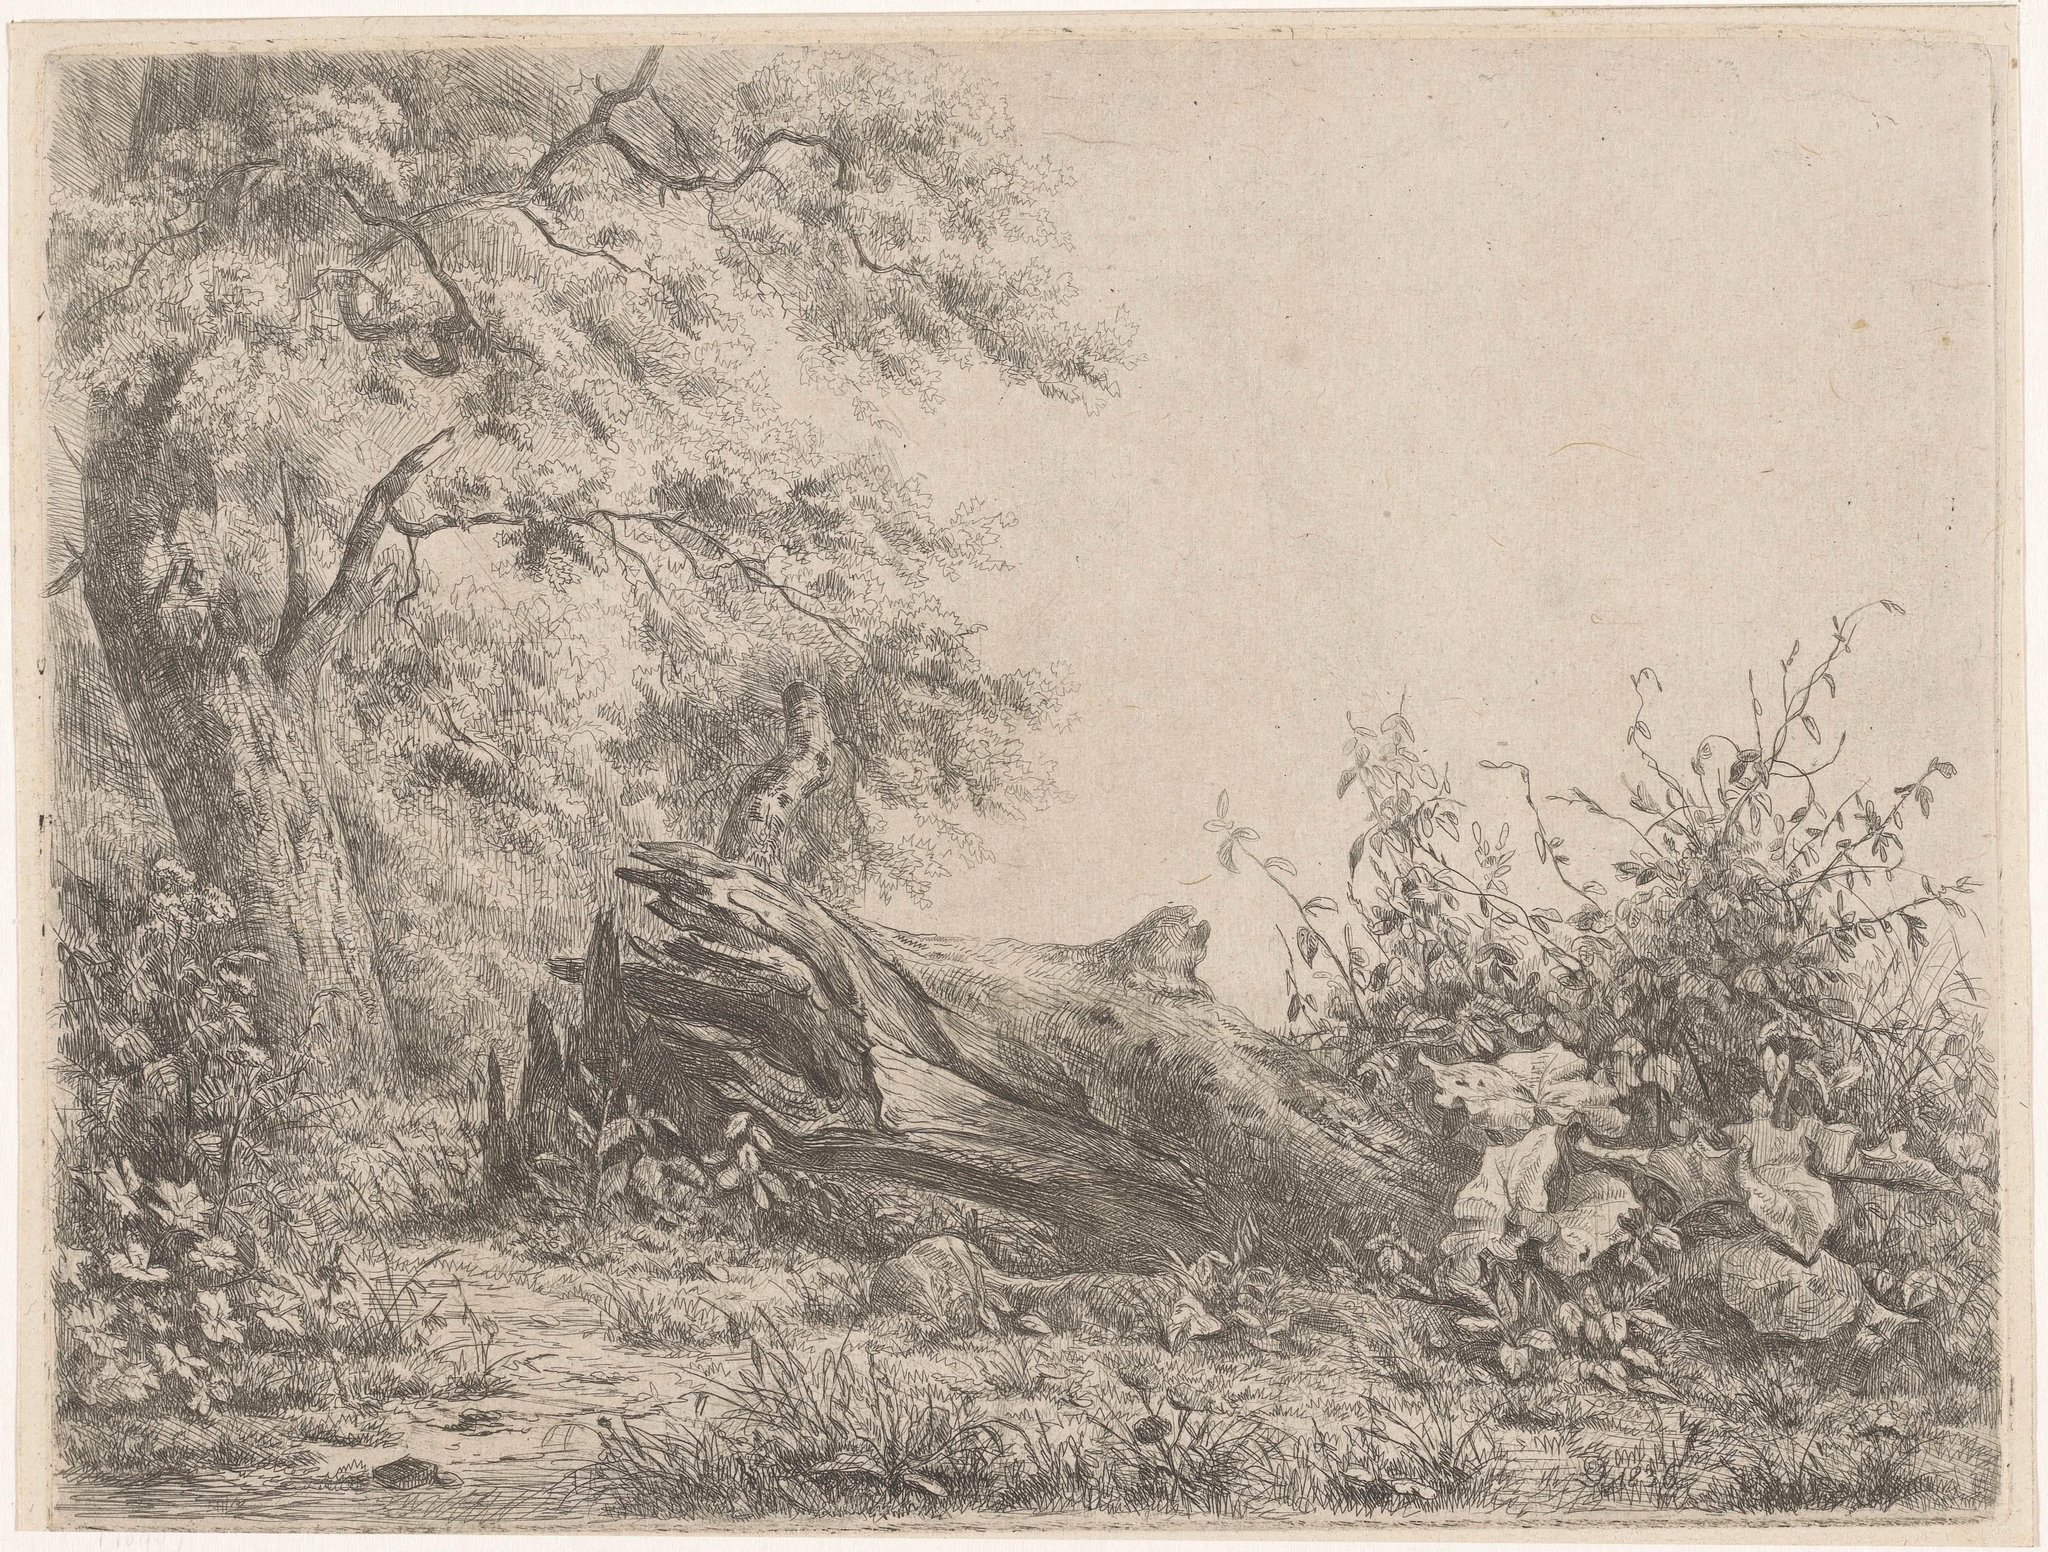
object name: print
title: Omgevallen boom aan de bosrand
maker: pierre louis dubourcq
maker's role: draughtsman, painter, print maker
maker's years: 1815-1873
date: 1836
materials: paper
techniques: etching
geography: netherlands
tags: trees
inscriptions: collector's mark: Lugt 2228